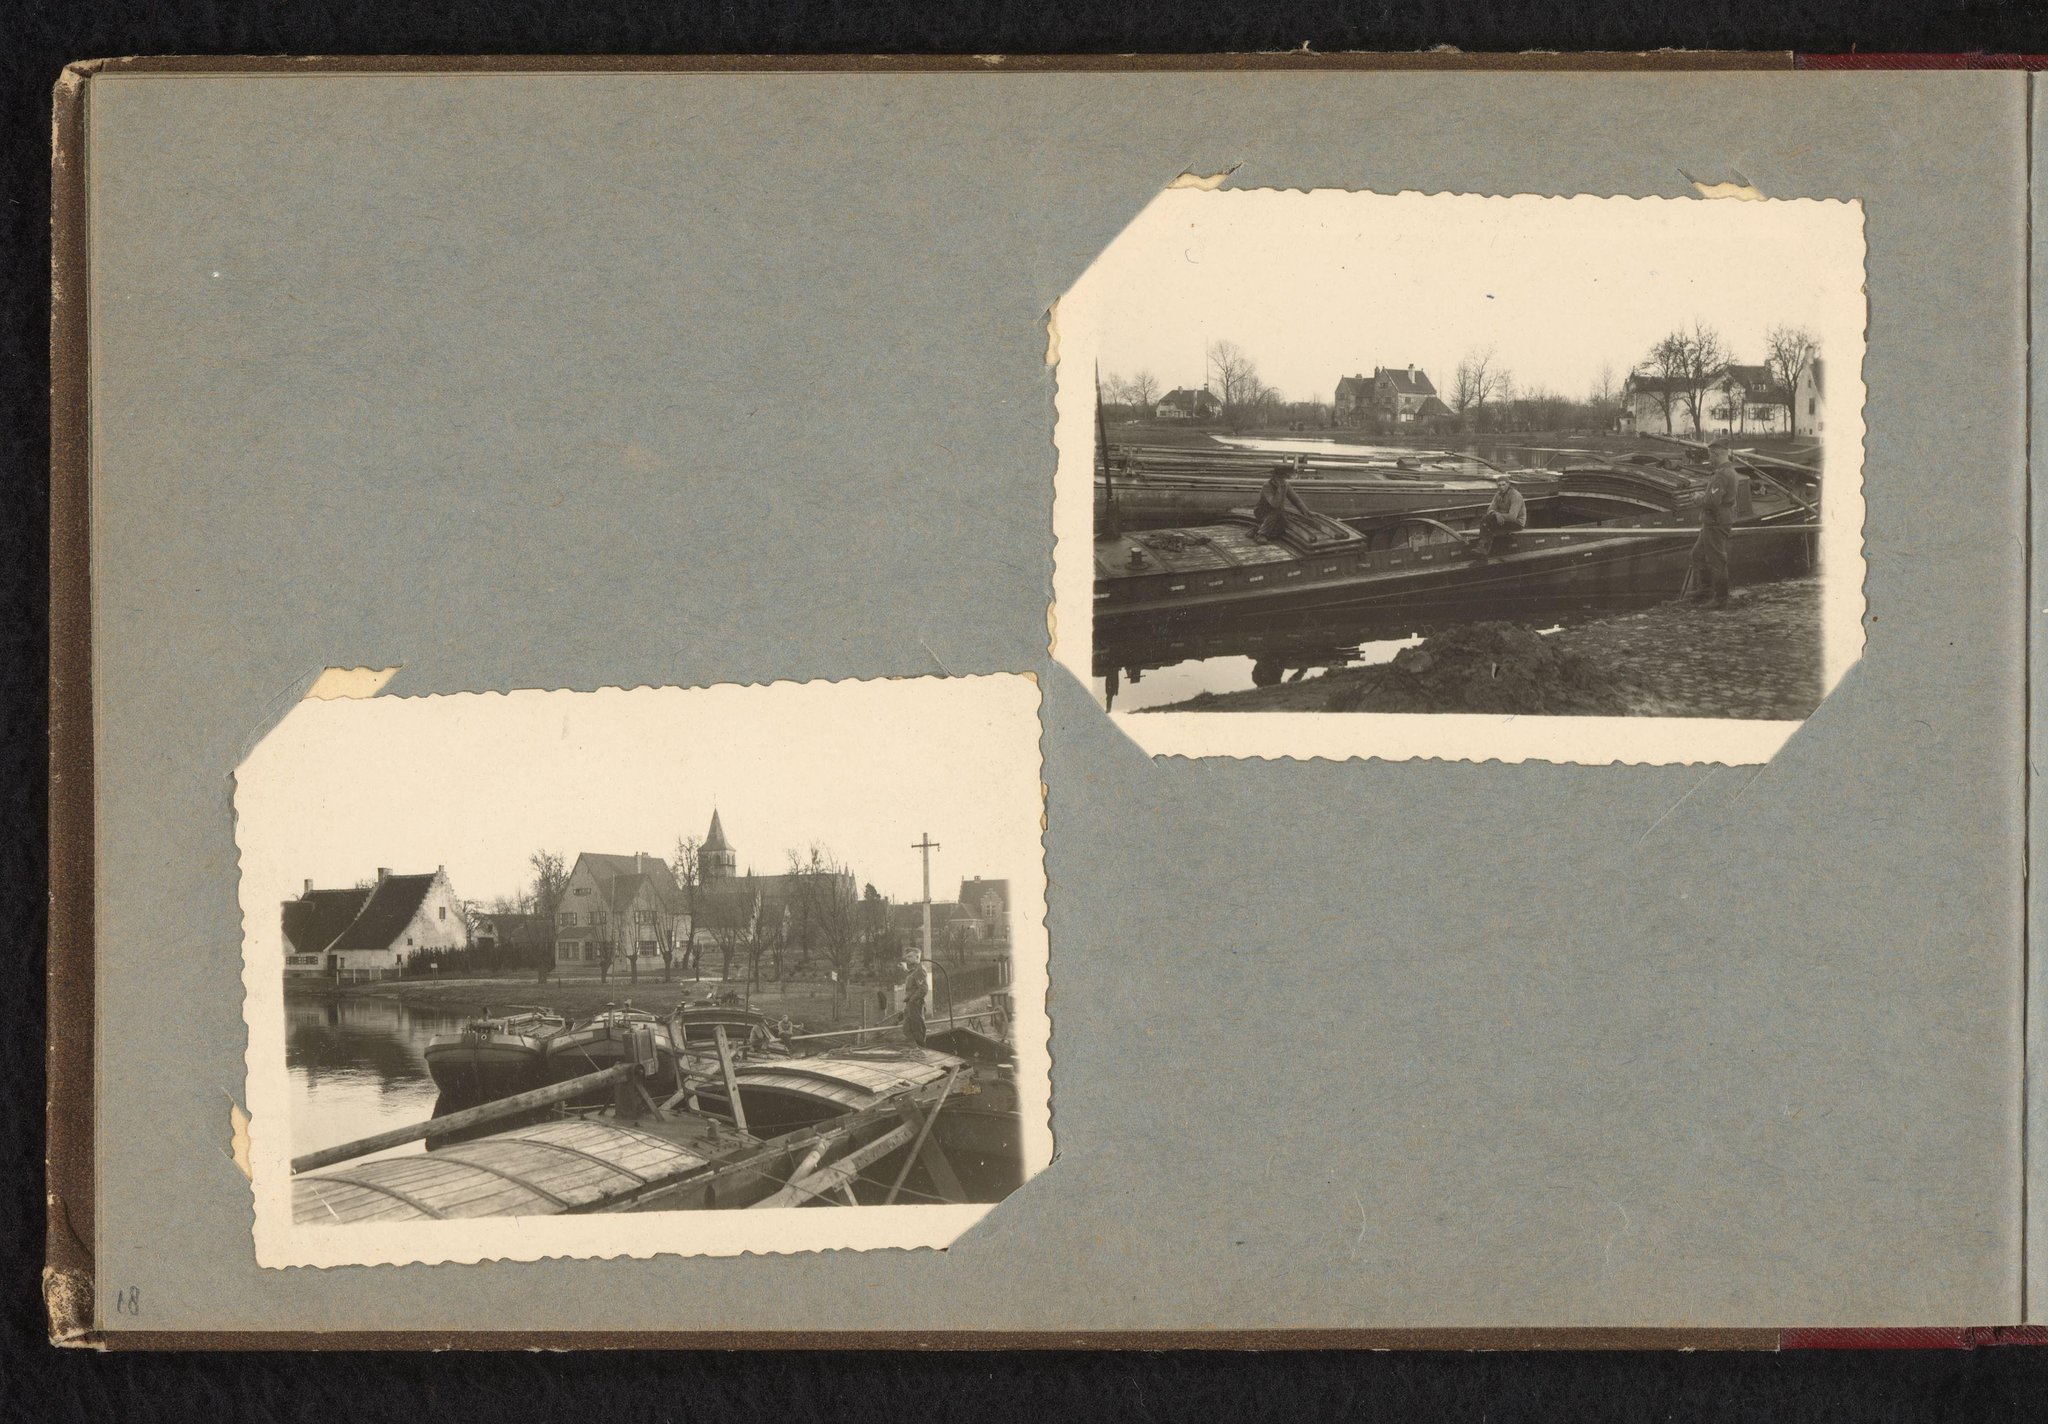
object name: photograph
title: Haven met boten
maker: Anonymous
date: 1940-1945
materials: paper, photographic support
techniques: gelatin silver print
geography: germany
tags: the company, the unit, the troop ~ military service, pier, quay, wharf, germany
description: Albumblad met twee foto's van Duitse militairen bij boten in een haven. Onderdeel van een fotoalbum over de diensttijd van Dieter Glitsch uit Hardegsen tijdens de Tweede Wereldoorlog en de jaren daarna.